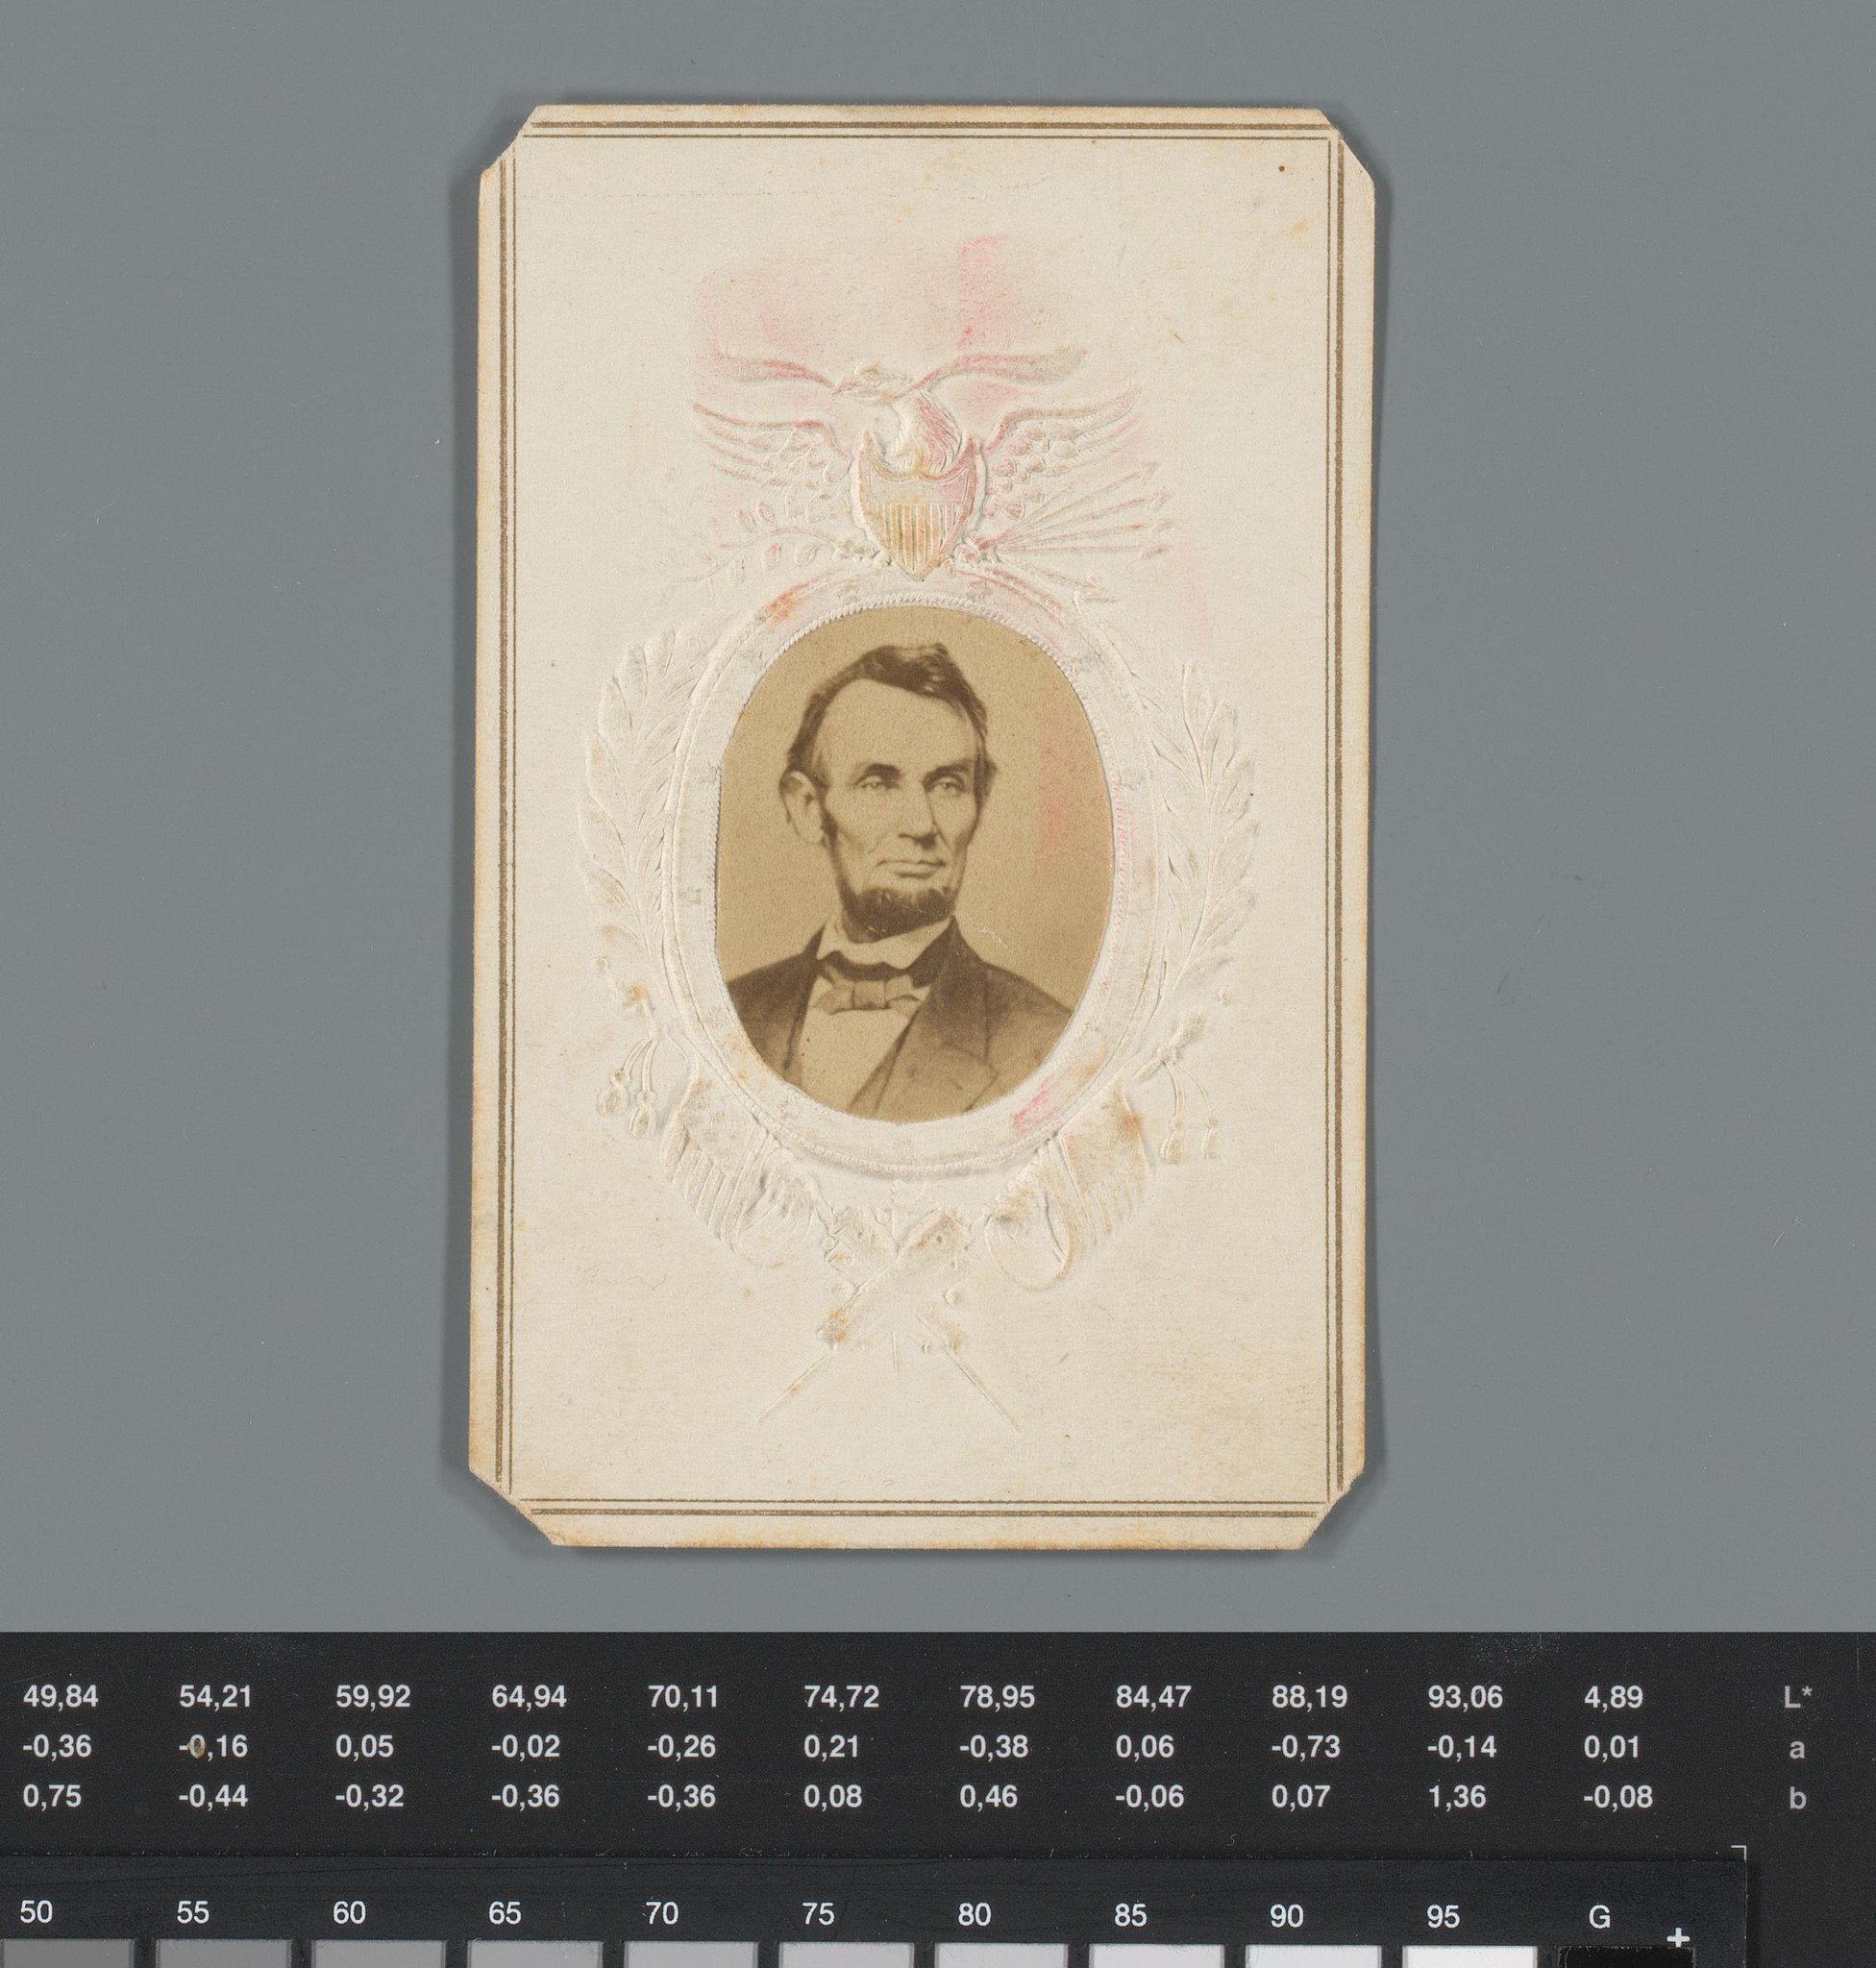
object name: carte de visite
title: Reclame voor gouden sierraden en cartes-de-visite van Salisbury Bro. & Co. met een portret van Abraham Lincoln en patriottisch gepreegd kader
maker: Anonymous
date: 1850-1915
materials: cardboard, photographic support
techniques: albumen print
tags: advertising, president ~ head of republic, historical persons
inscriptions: inscription: ‘SALISBURY BRO. & CO., (...) / GOLD AND GOLD PLATED JUWELRY (...)’